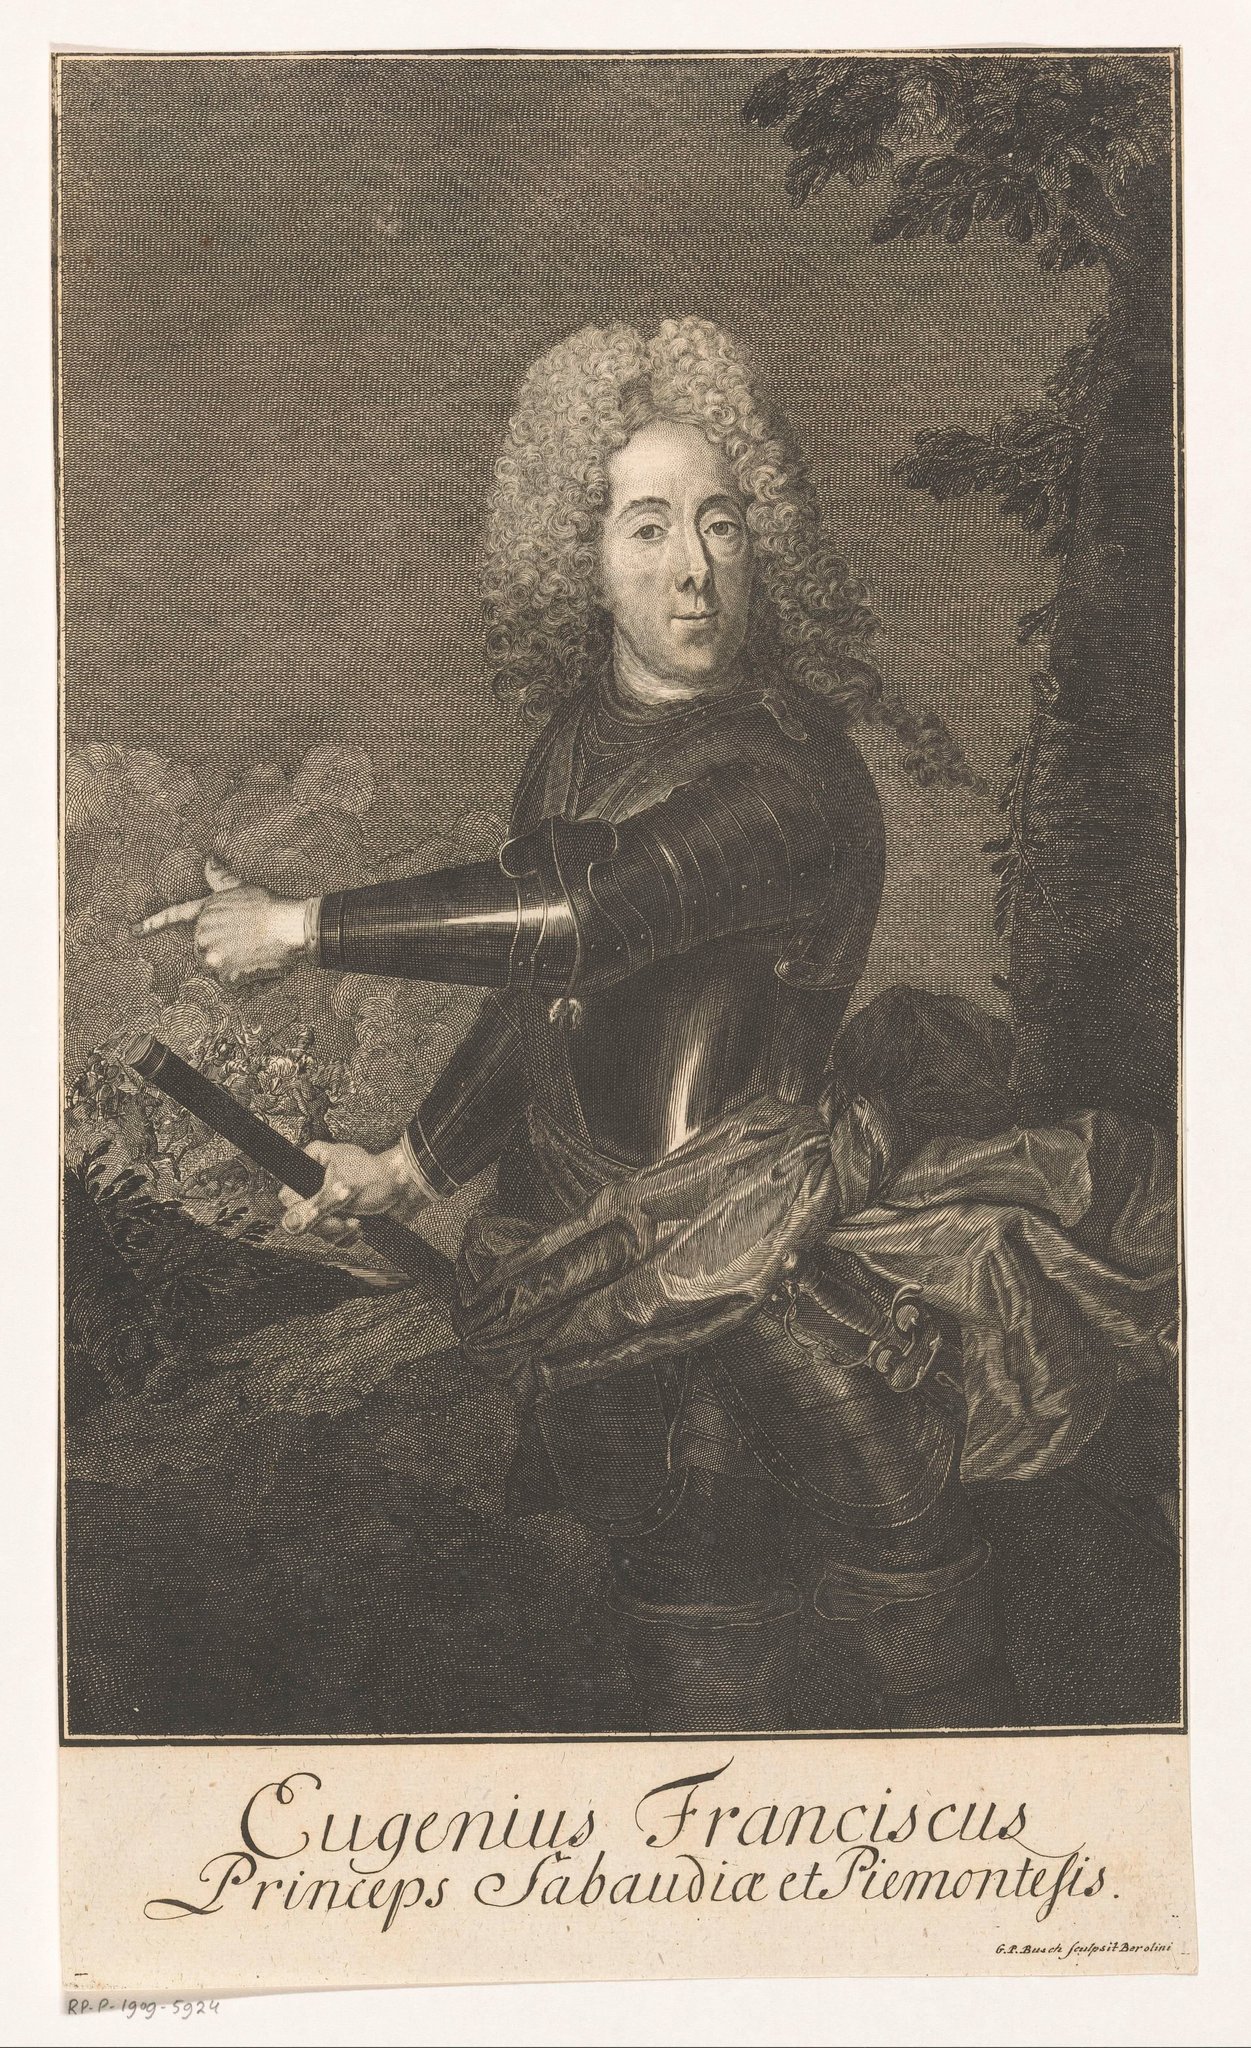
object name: print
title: Portret van Eugenius van Savoye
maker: georg paul busch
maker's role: print maker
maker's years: -1756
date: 1716-1756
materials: paper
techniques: engraving, etching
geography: berlin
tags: paris, vienna, eugenius van savoye, charge ~ battle (+ cavalry, horsemen), armour, historical persons, knighthood order of the golden fleece - insignia of a knighthood order, e.g.: badge, chain (with name of order), baton of general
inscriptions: collector's mark: Lugt 2228